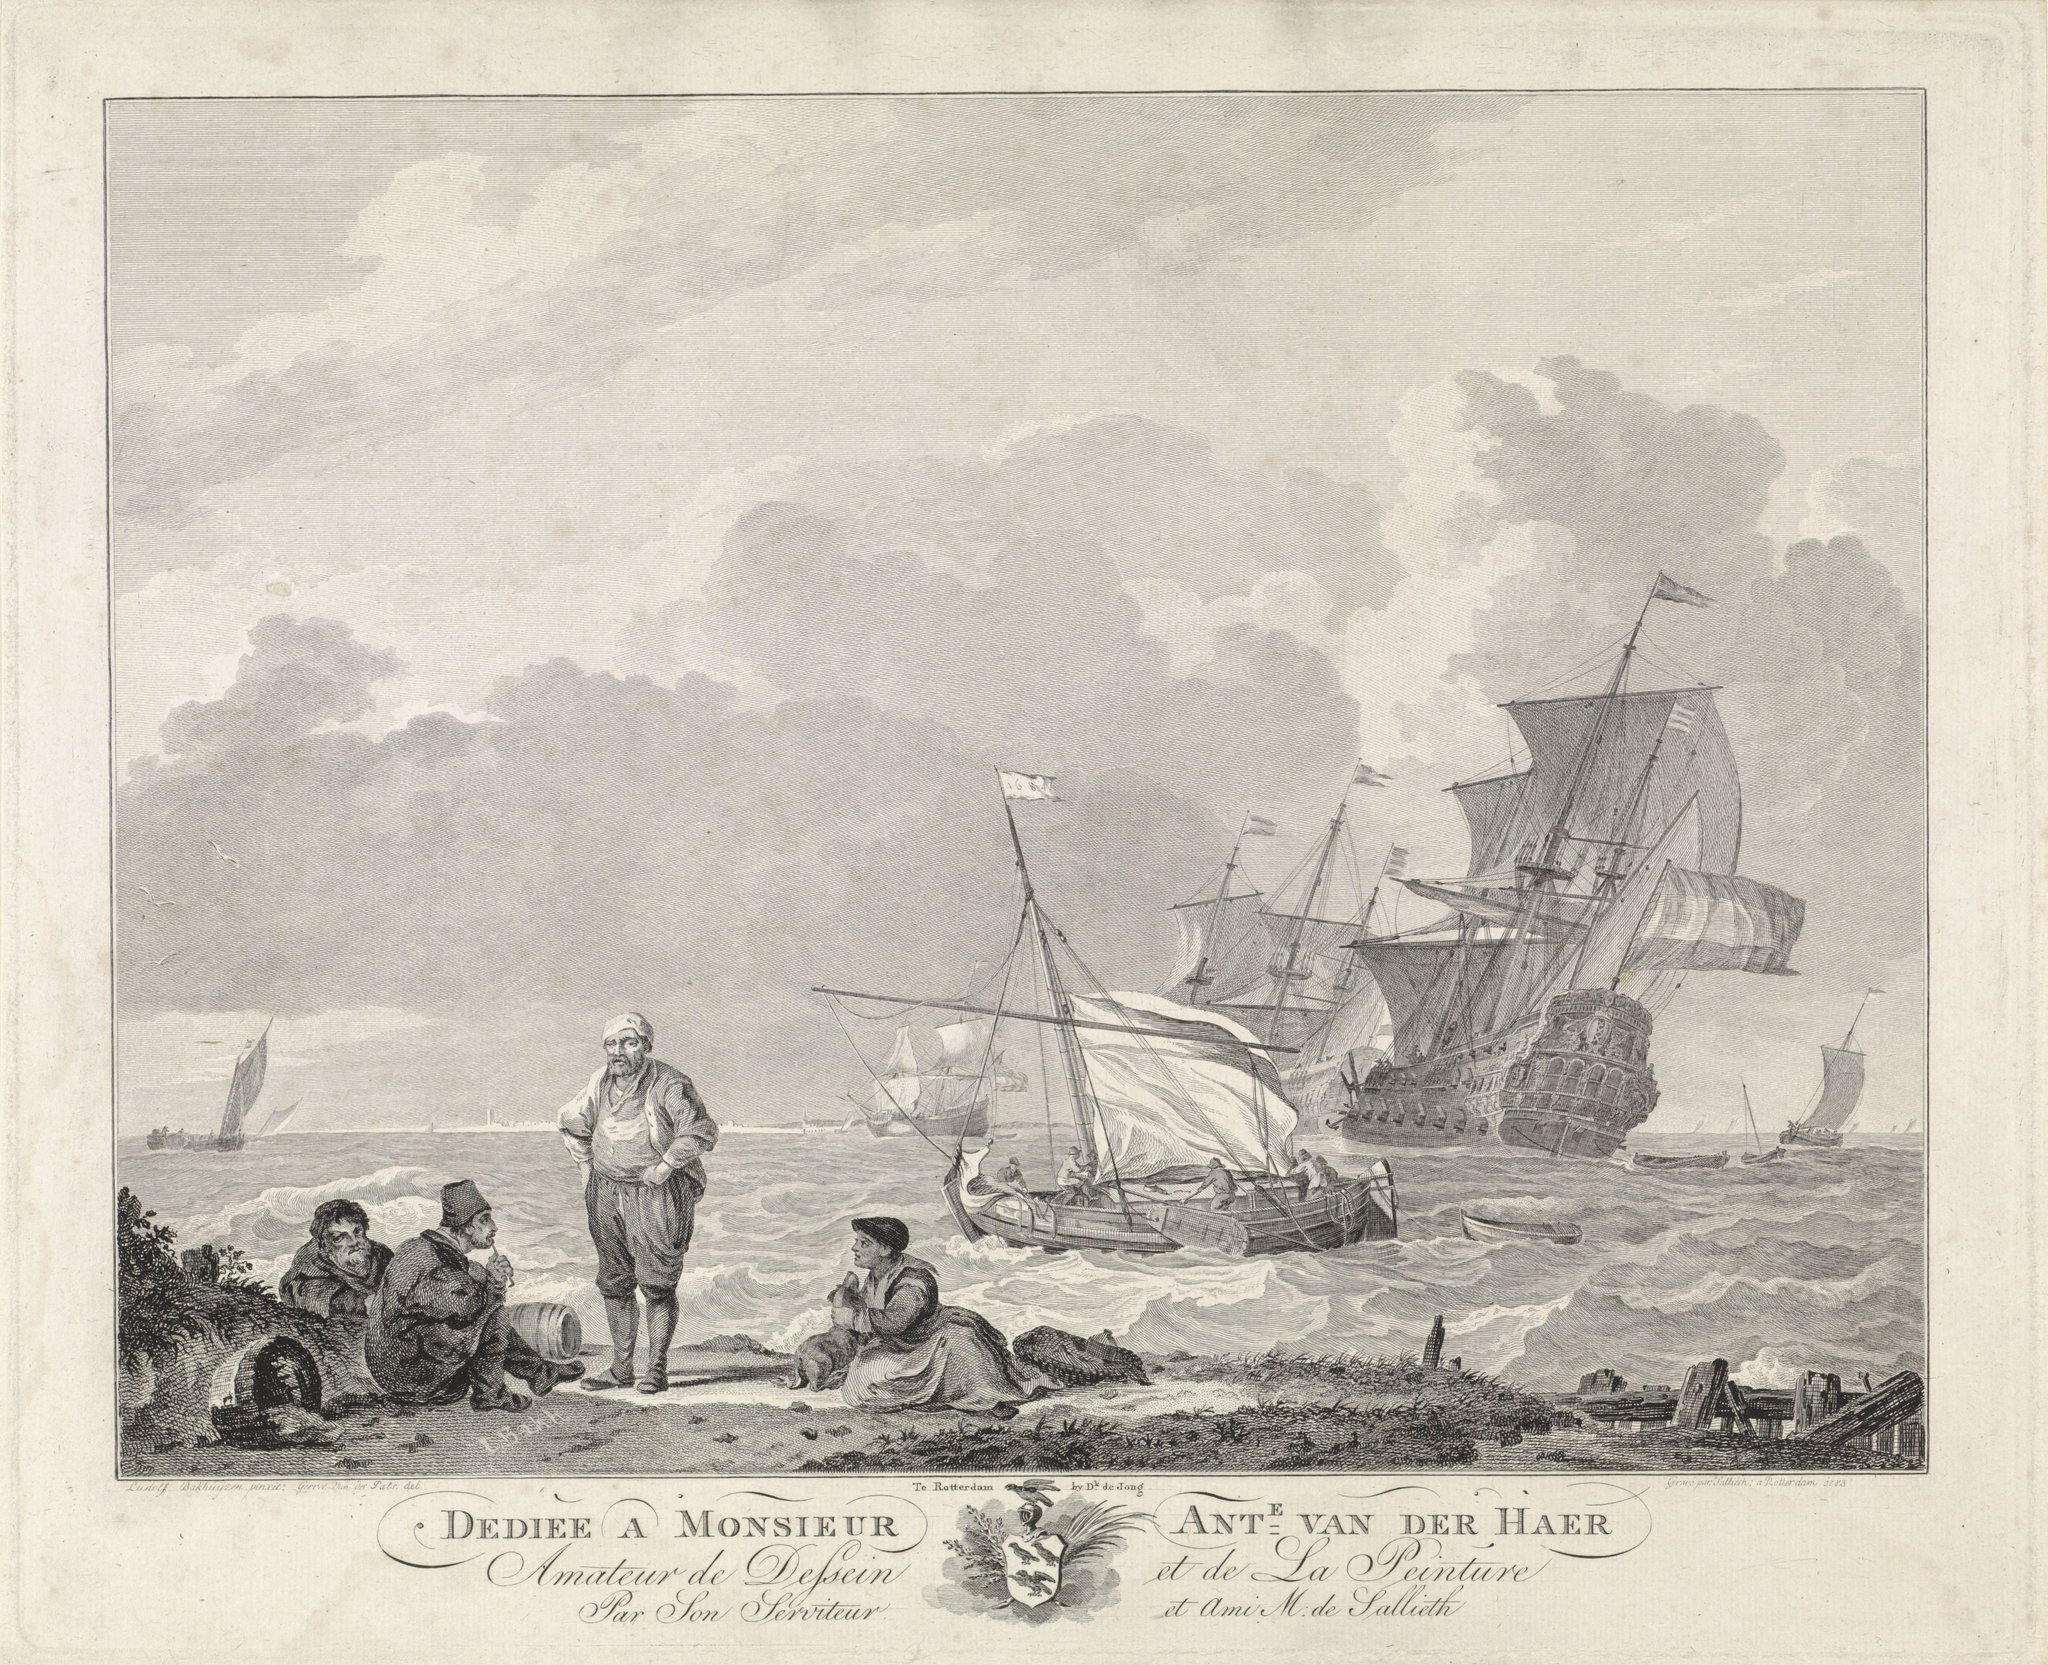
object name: print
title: Strandgezicht met figuren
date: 1783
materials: paper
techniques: etching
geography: amsterdam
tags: coat of arms (as symbol of the state, etc.) (+ city; municipal), sailing-ship, sailing-boat, beach, dog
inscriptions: collector's mark: Lugt 2228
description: Strandgezicht met vier figuren en een hond. Op zee varen een platbodem en enkele oorlogsschepen.